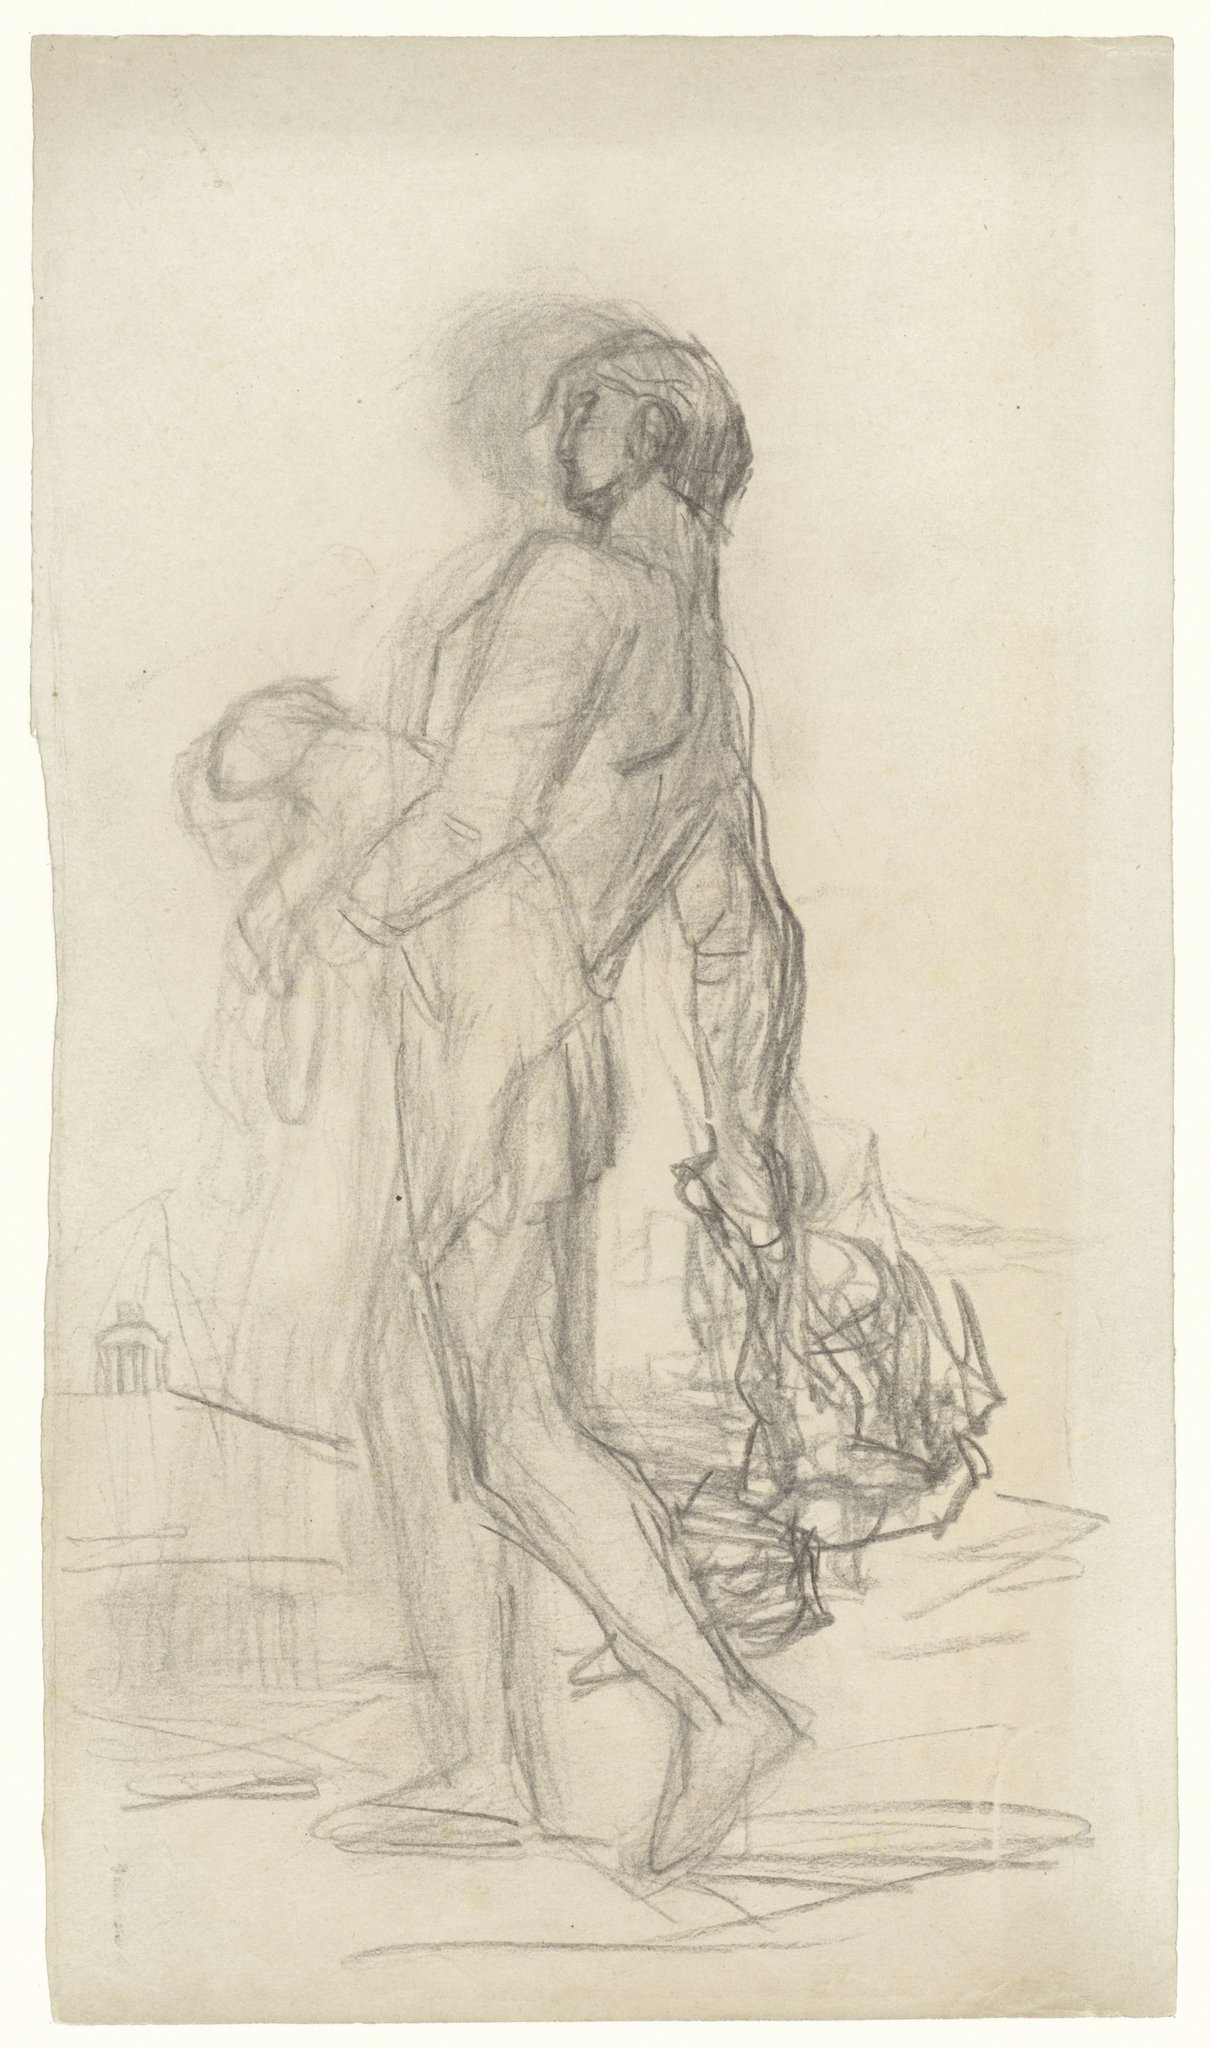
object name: drawing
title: Lopende man met een lam en een vogel als offerdieren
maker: matthijs maris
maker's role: draughtsman, painter, print maker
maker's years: 1839-1917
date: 1849-1917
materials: chalk, paper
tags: animal sacrifice ~ non-christian religions